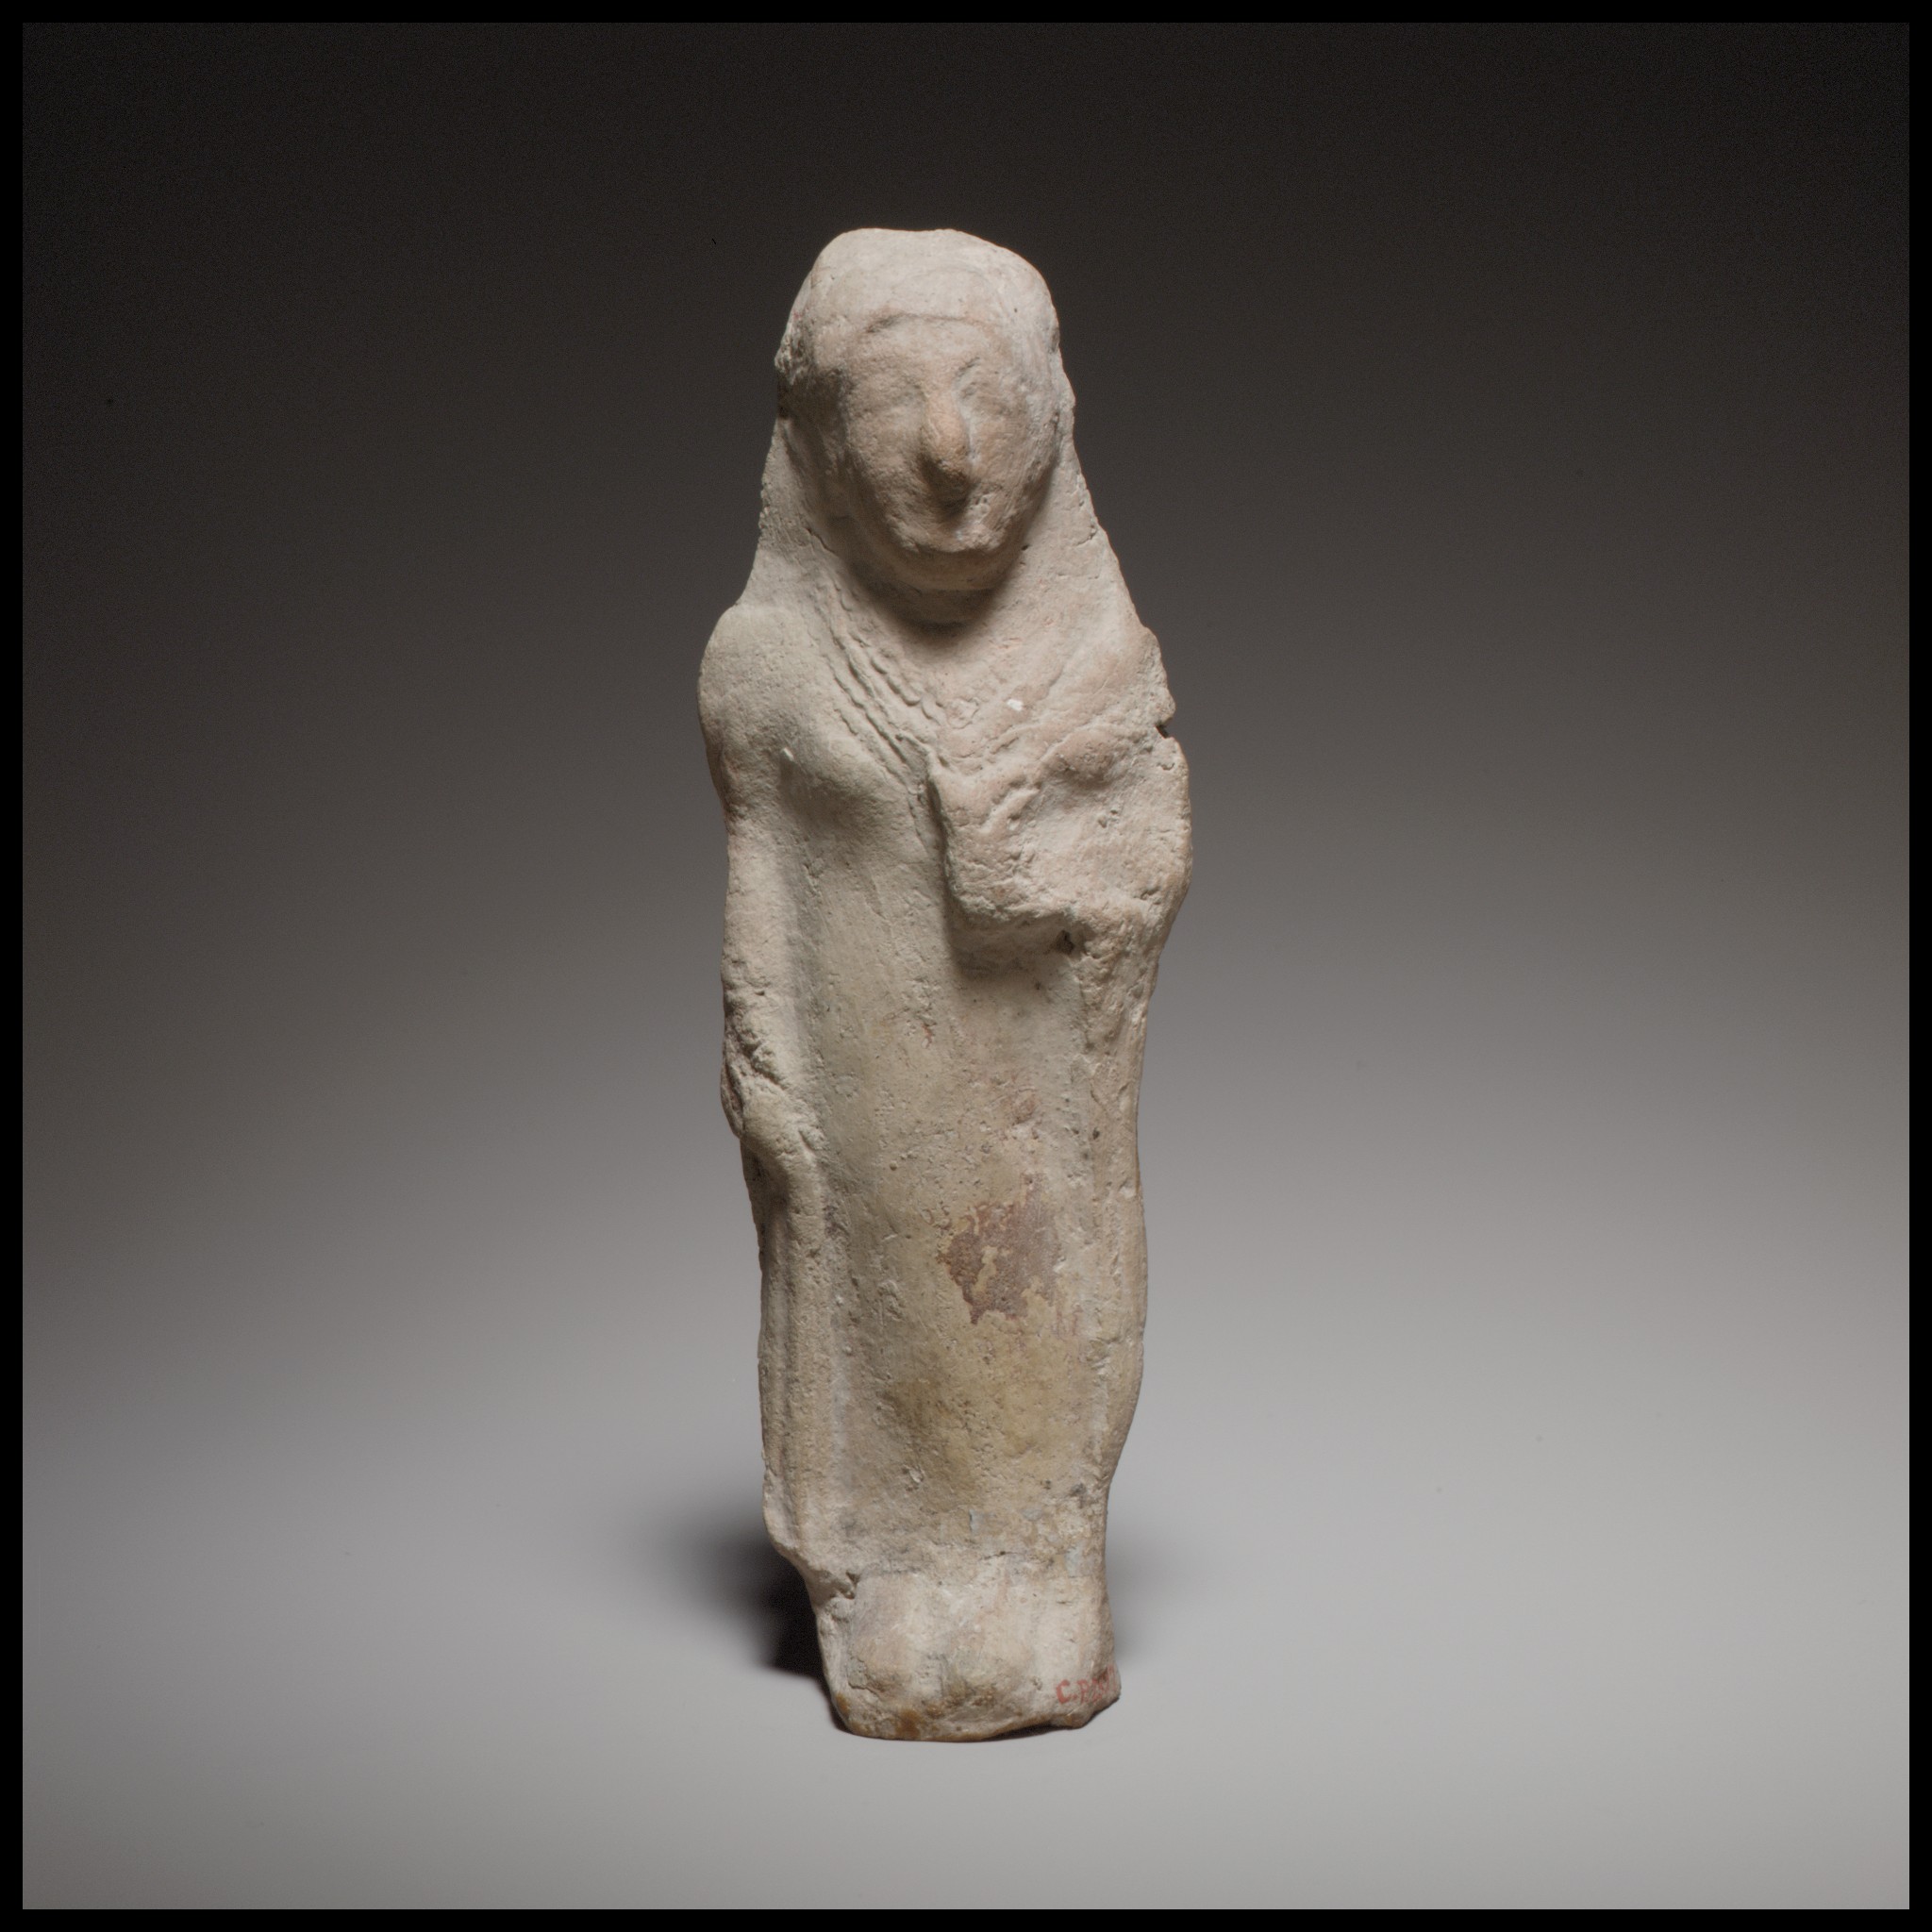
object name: statuette of a woman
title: Standing female figurine holding a flower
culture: cypriot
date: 600-480 BCE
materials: terracotta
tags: women